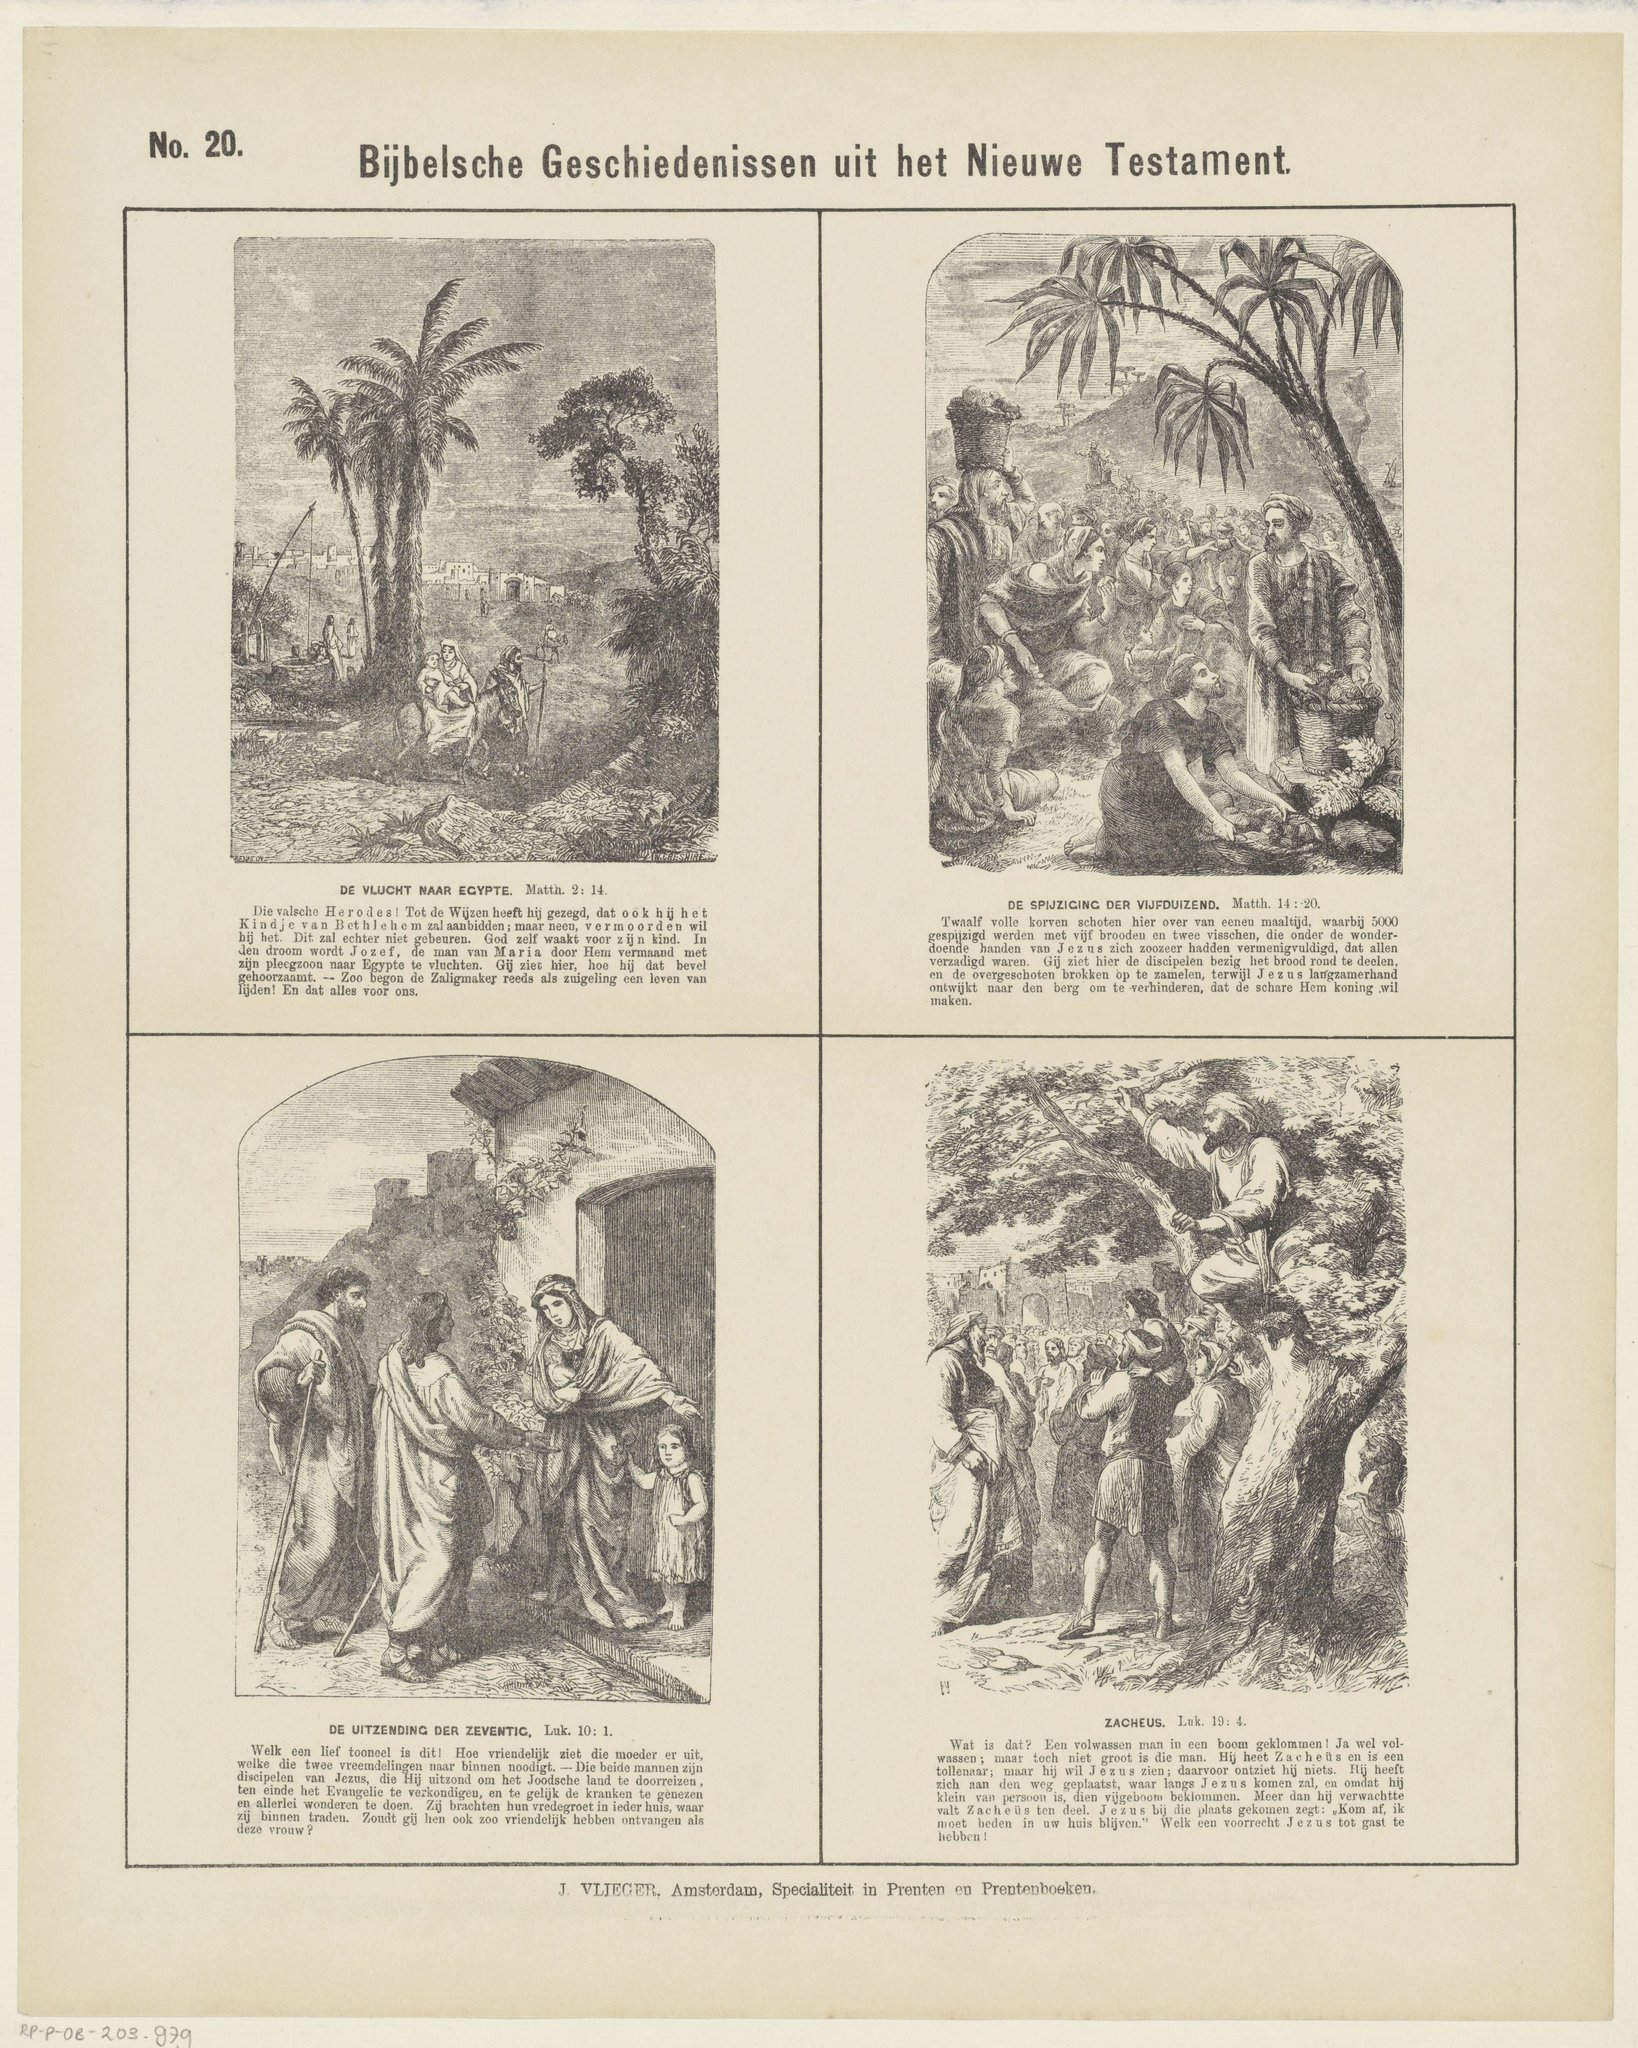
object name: print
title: Bijbelsche geschiedenissen uit het Nieuwe Testament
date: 1871-1908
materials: paper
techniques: letterpress printing, engraving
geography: amsterdam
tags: the flight into egypt: mary, joseph, the child (and sometimes others) on their way; mary usually riding on an ass, multiplication of loaves and fishes for a multitude of four or five thousand people (matthew 14:13-21, 15:32-39; mark 6:32-44, 8:1-10; luke 9:10-17; john 6:1-14), calling of zacchaeus, who is sitting in a fig-tree (christ passing through jericho), new testament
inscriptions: collector's mark: Lugt 2760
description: Blad met 4 voorstellingen van verhalen uit het Nieuwe Testament. De vlucht naar Egypte, de spijziging van vijfduizend, de uitzending der zeventig en Zacheüs in een vijgenboom. Onder elke afbeelding de bijbehorende Bijbeltekst. Genummerd linksboven: No. 20.